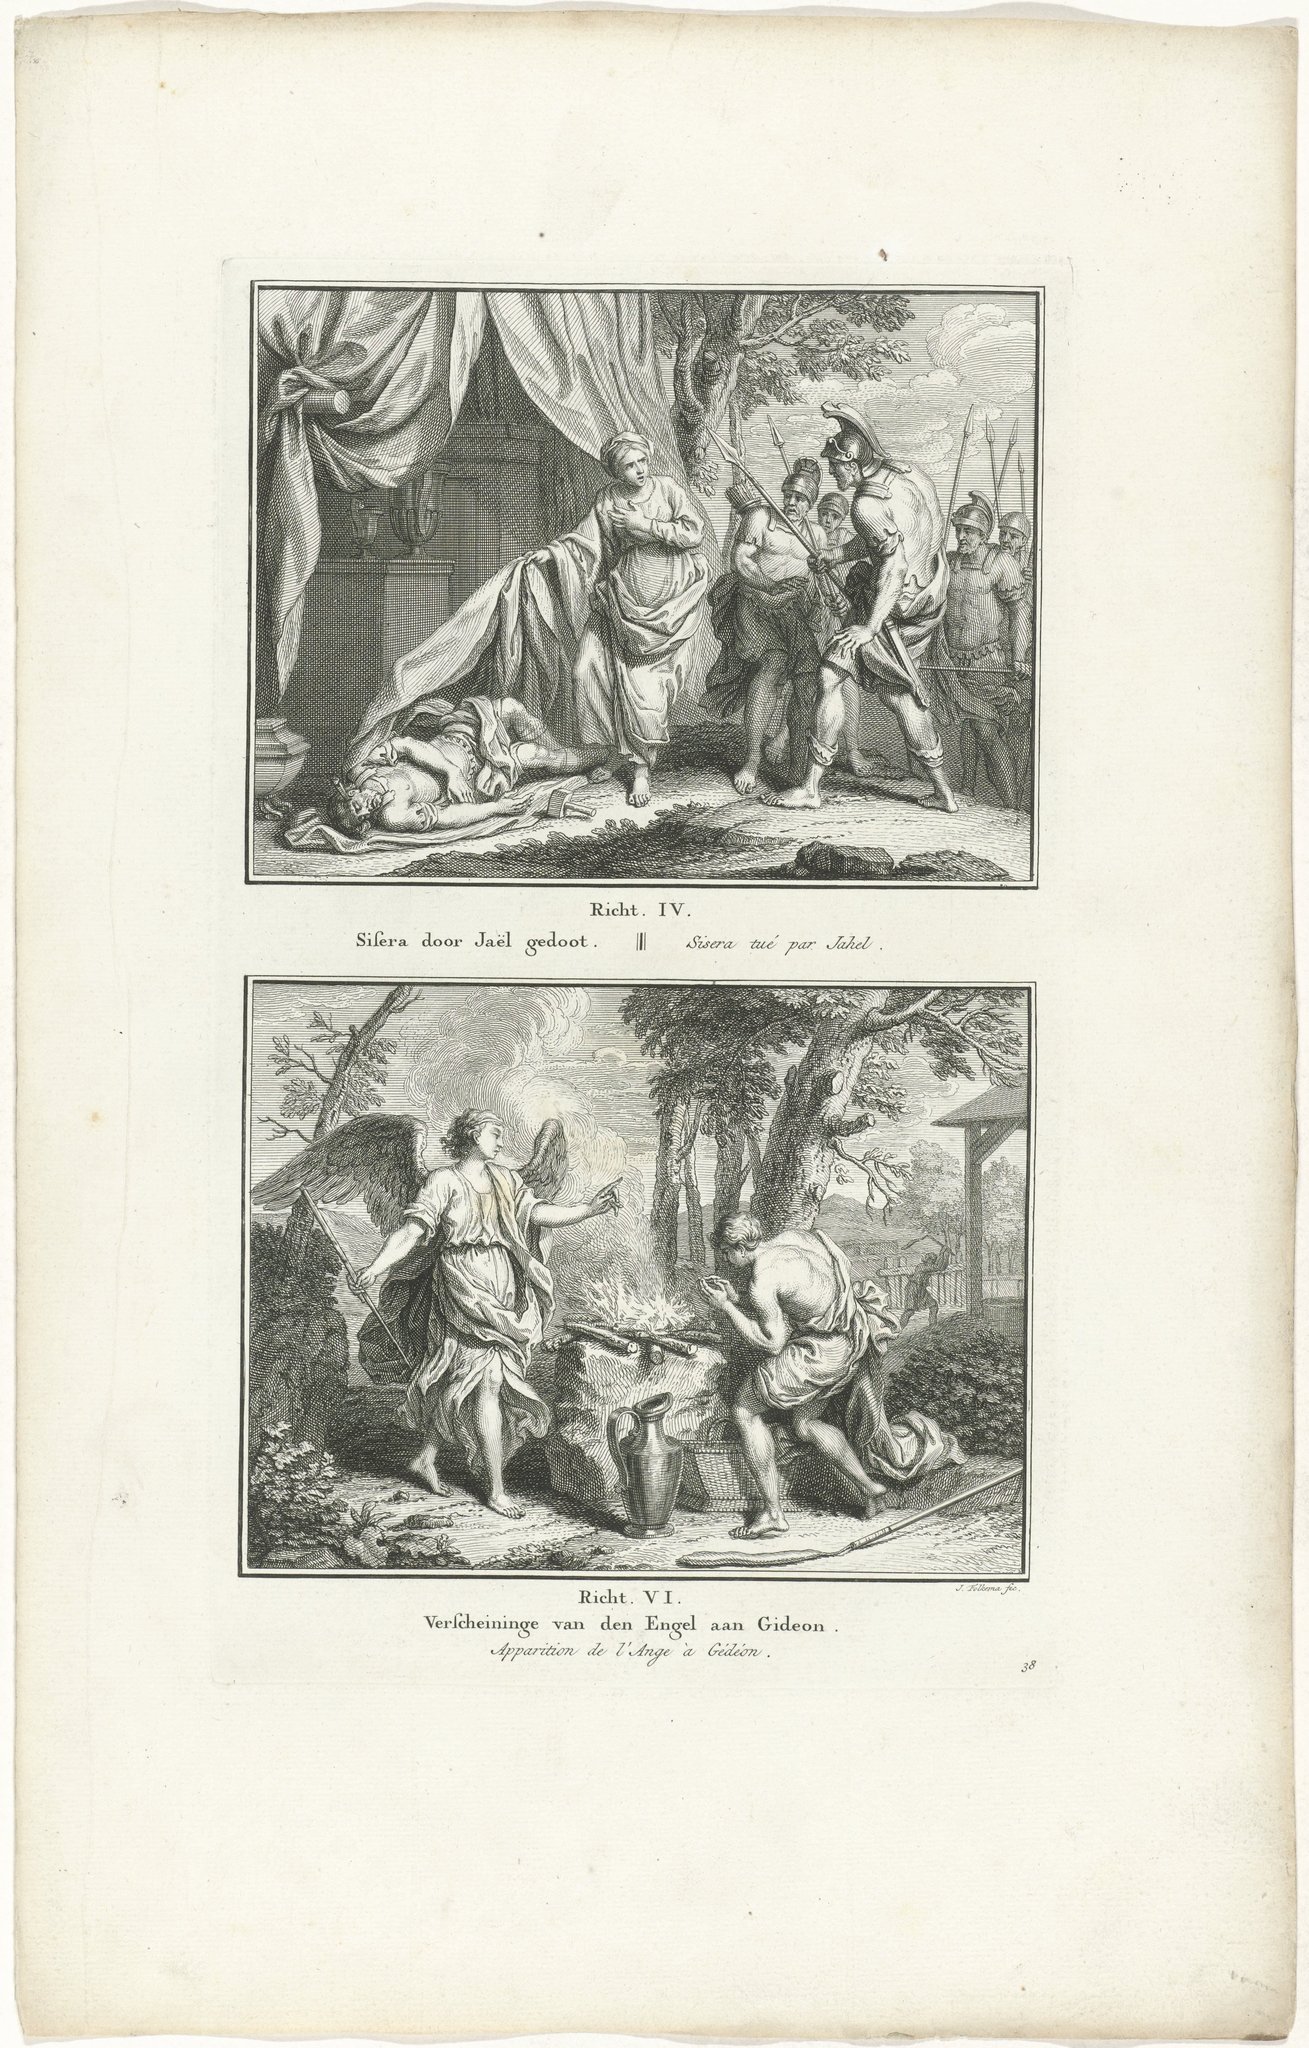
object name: book illustration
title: Jael doodt Sisera en de Engel des Heren verschijnt aan Gideon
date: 1791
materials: paper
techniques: etching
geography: amsterdam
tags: jael kills the sleeping sisera by hitting the nail through his temples, gideon and the angel of the lord (judges 6:11-24)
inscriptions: collector's mark, collector's mark: Lugt 2233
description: Illustratie uit: Hamelsveld, Ysbrand van. De gewigtigste geschiedenissen des Bybels, afgebeeld in twee honderd twee en vijftig printverbeeldingen (...) met eene zaaklijke uitbreiding opgehelderd. Amsterdam / Dordrecht: Jan de Groot / Abraham en Pieter Blussé.